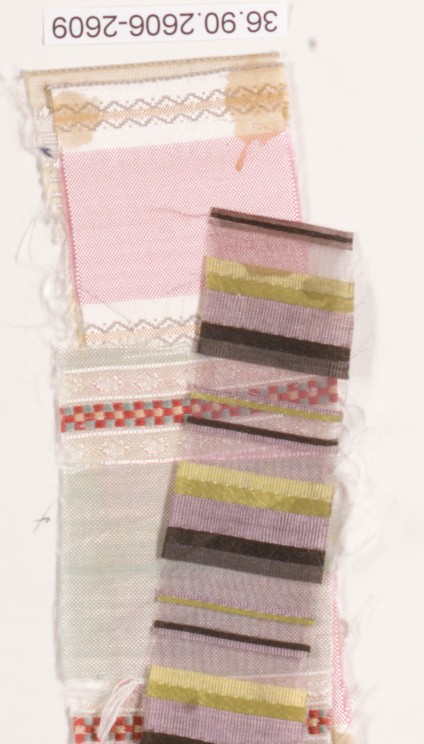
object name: ribbon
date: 1801-1900